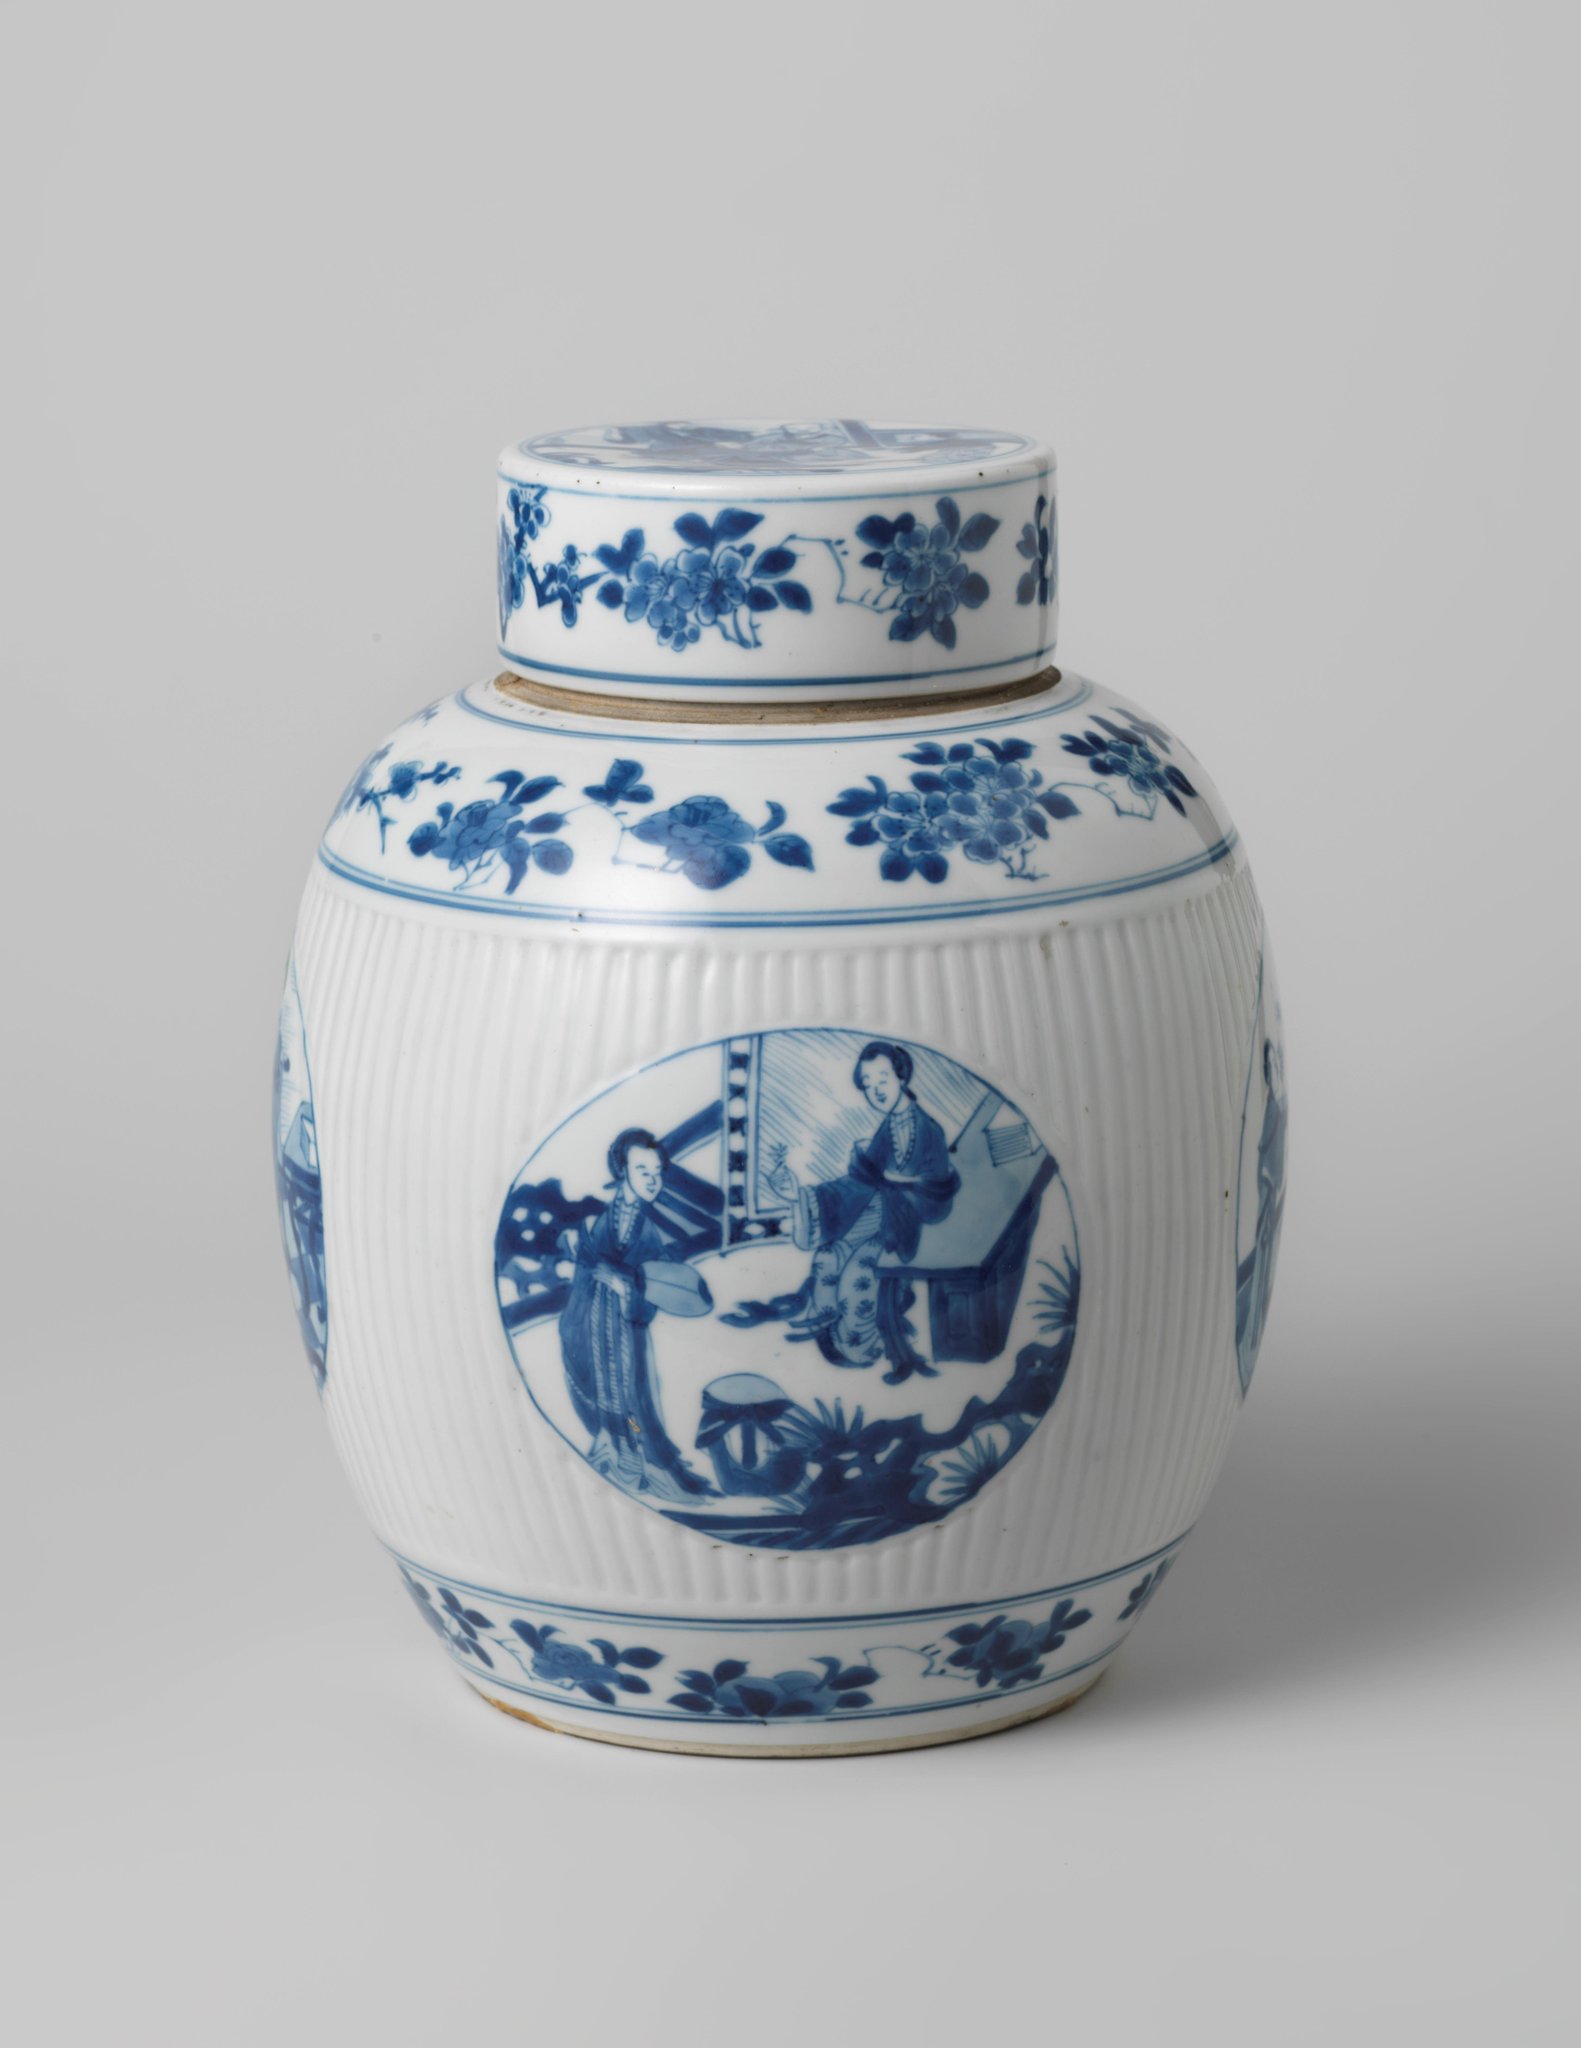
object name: covered jar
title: Ovoid covered jar with flower sprays and narrative scenes in medallions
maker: Anonymous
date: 1680-1720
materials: cobalt, glaze, paint, porcelain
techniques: firing, forming, turning, vitrification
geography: china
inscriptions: mark: ‘大 明 成 化 年 製’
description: Gemberpot, met deksel, geribd, op de wand vier medaillons met huiselijke taferelen, onder en boven een rand van takken.